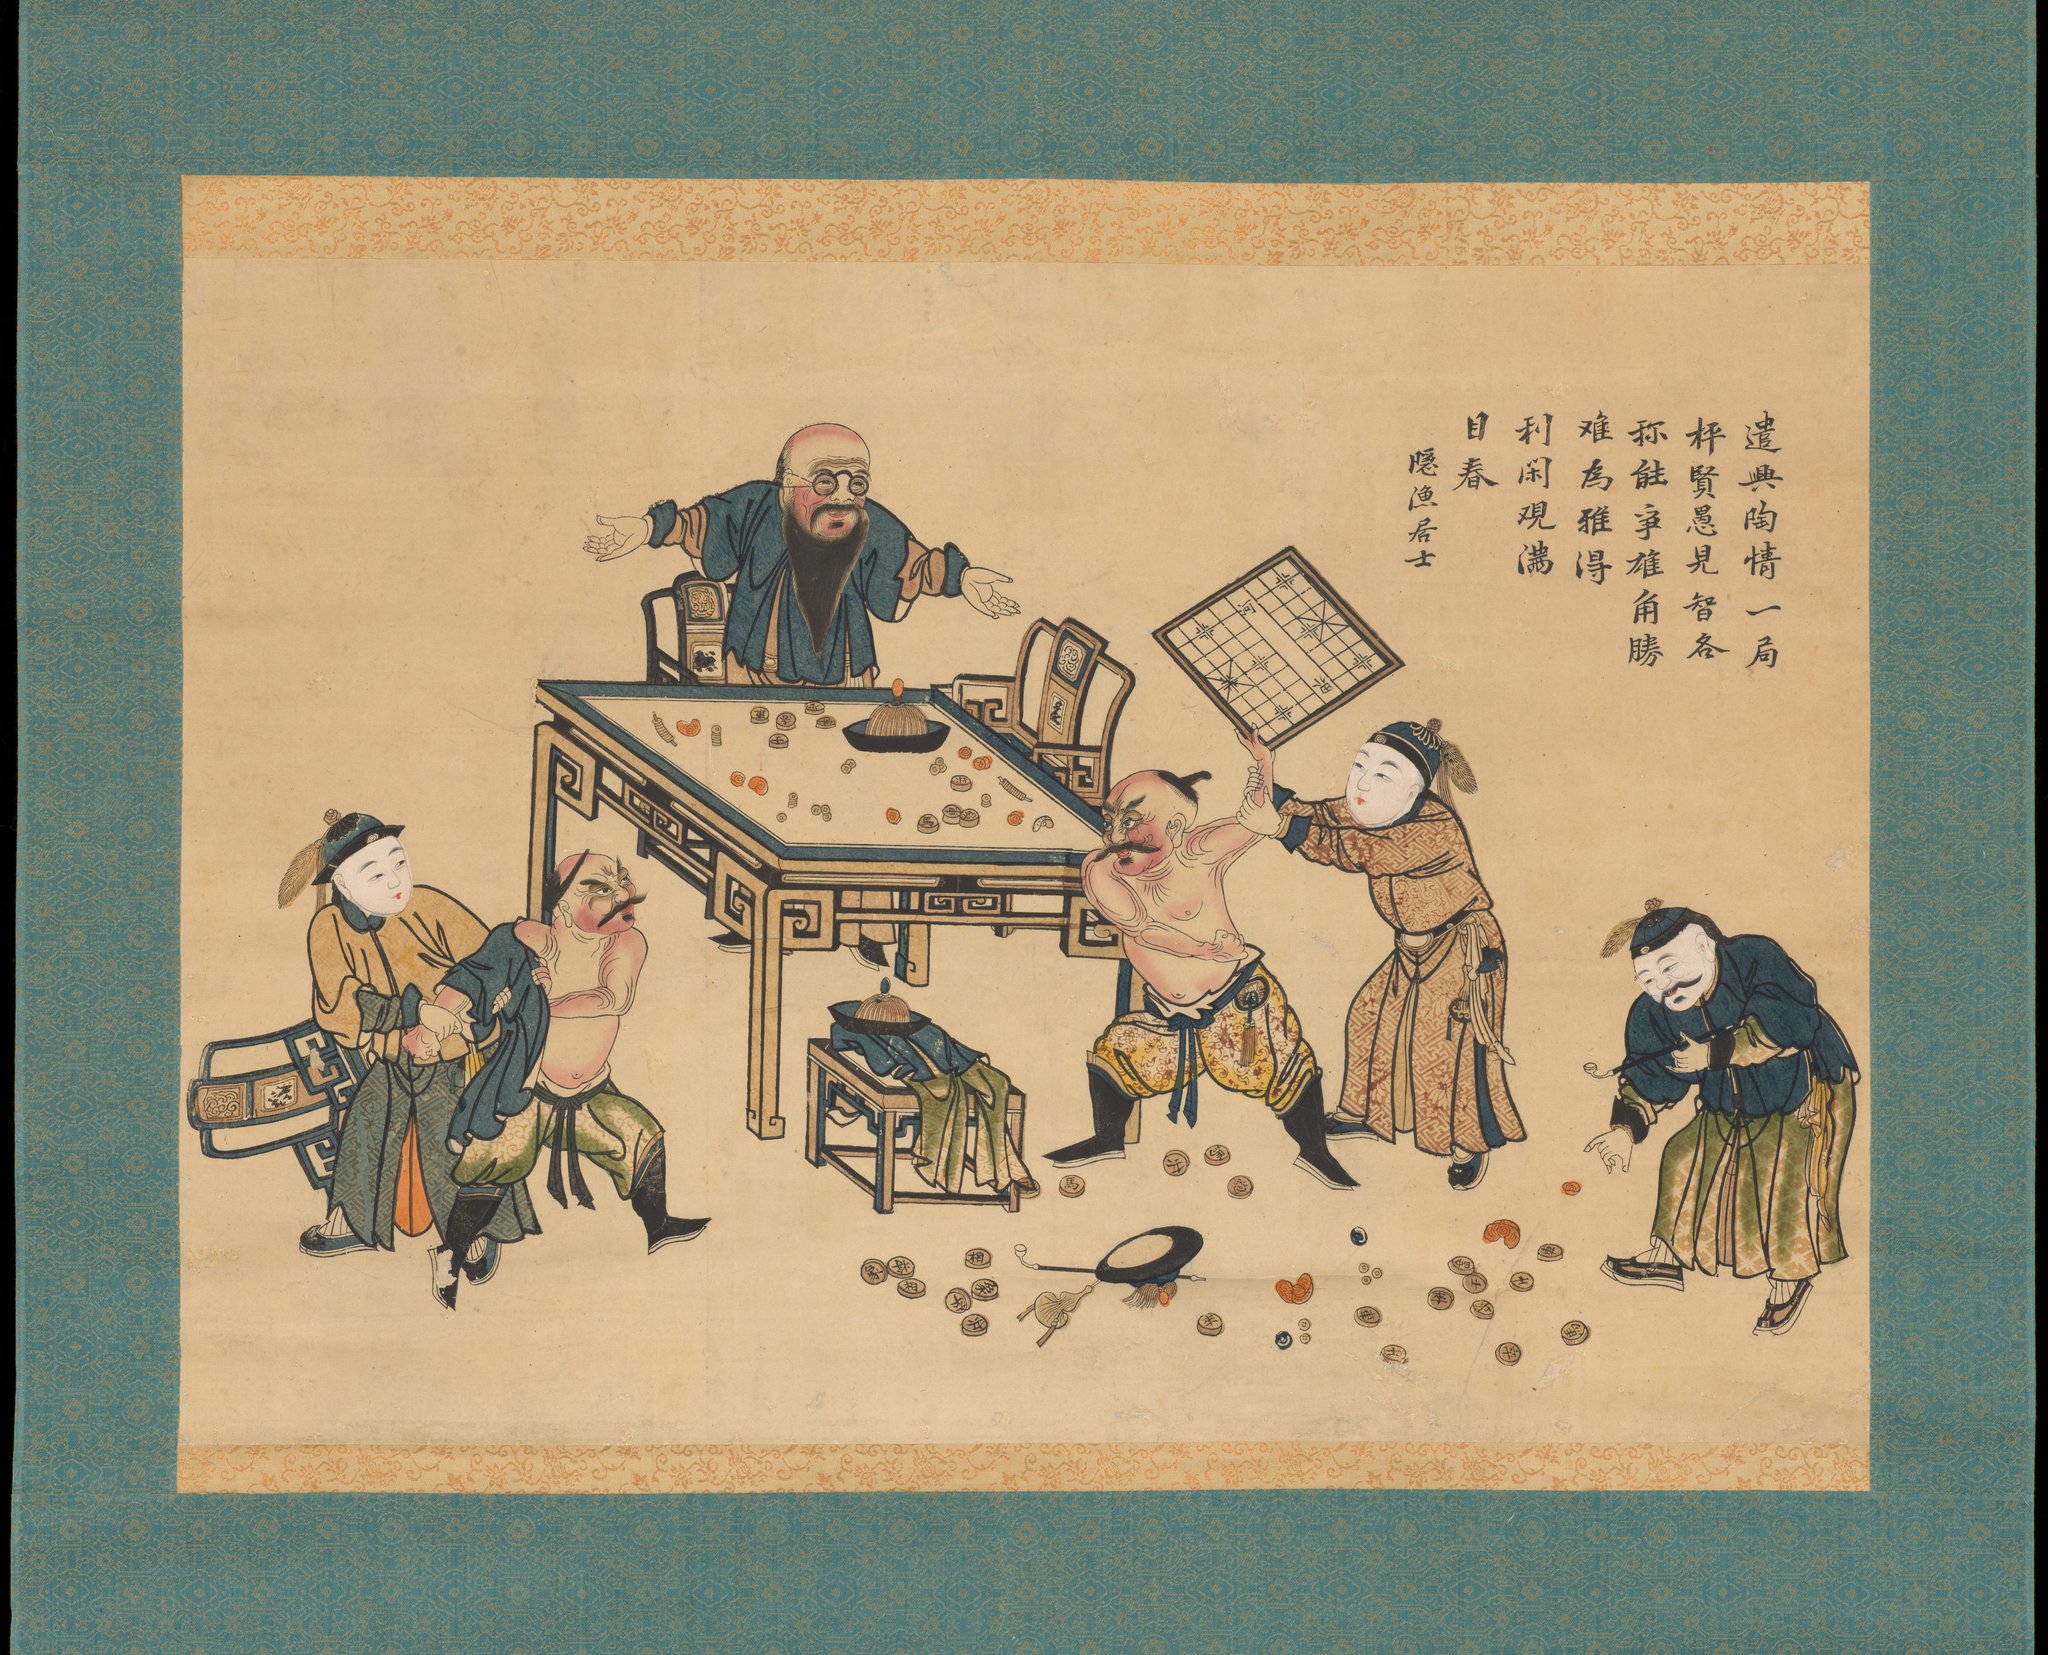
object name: print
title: Manchus Quarrel During a Chess Game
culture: chinese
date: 1736-1795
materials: ink, paper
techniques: hand coloring, woodblock print